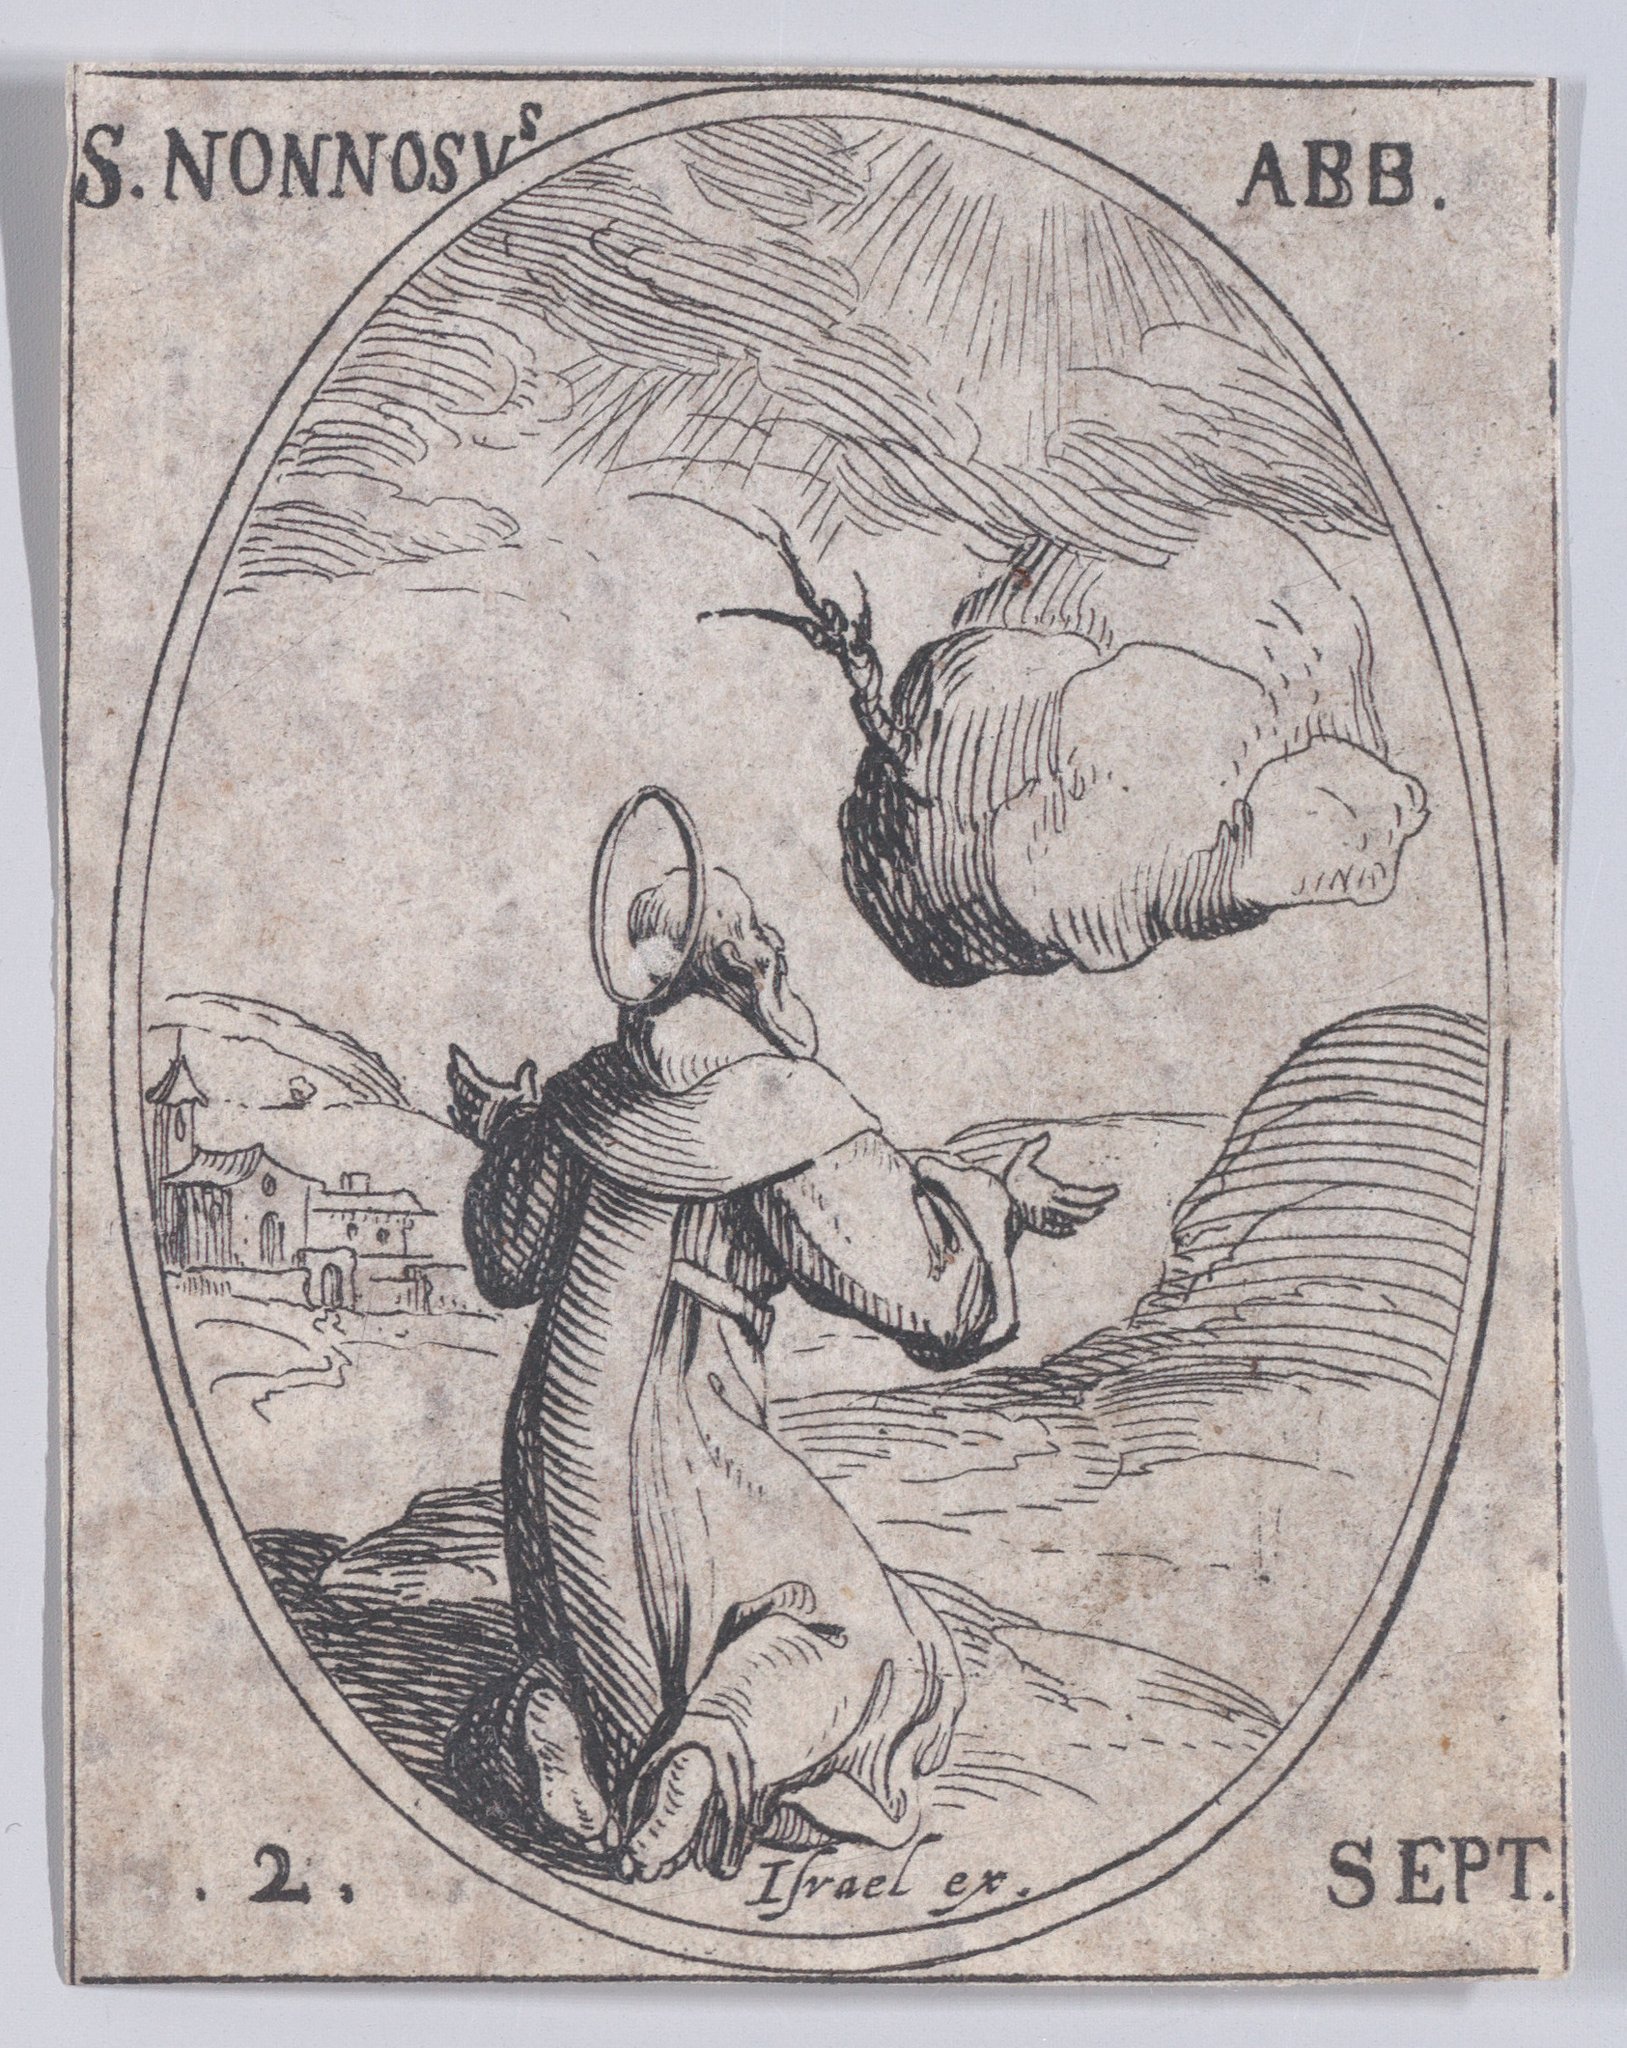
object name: print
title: S. Nonnose, abbé (St. Nonossus, Abbot), September 2nd, from "Les Images De Tous Les Saincts et Saintes de L'Année" (Images of All of the Saints and Religious Events of the Year)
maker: jacques callot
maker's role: artist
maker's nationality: french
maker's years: 1592-1635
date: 1636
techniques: etching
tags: men,saints